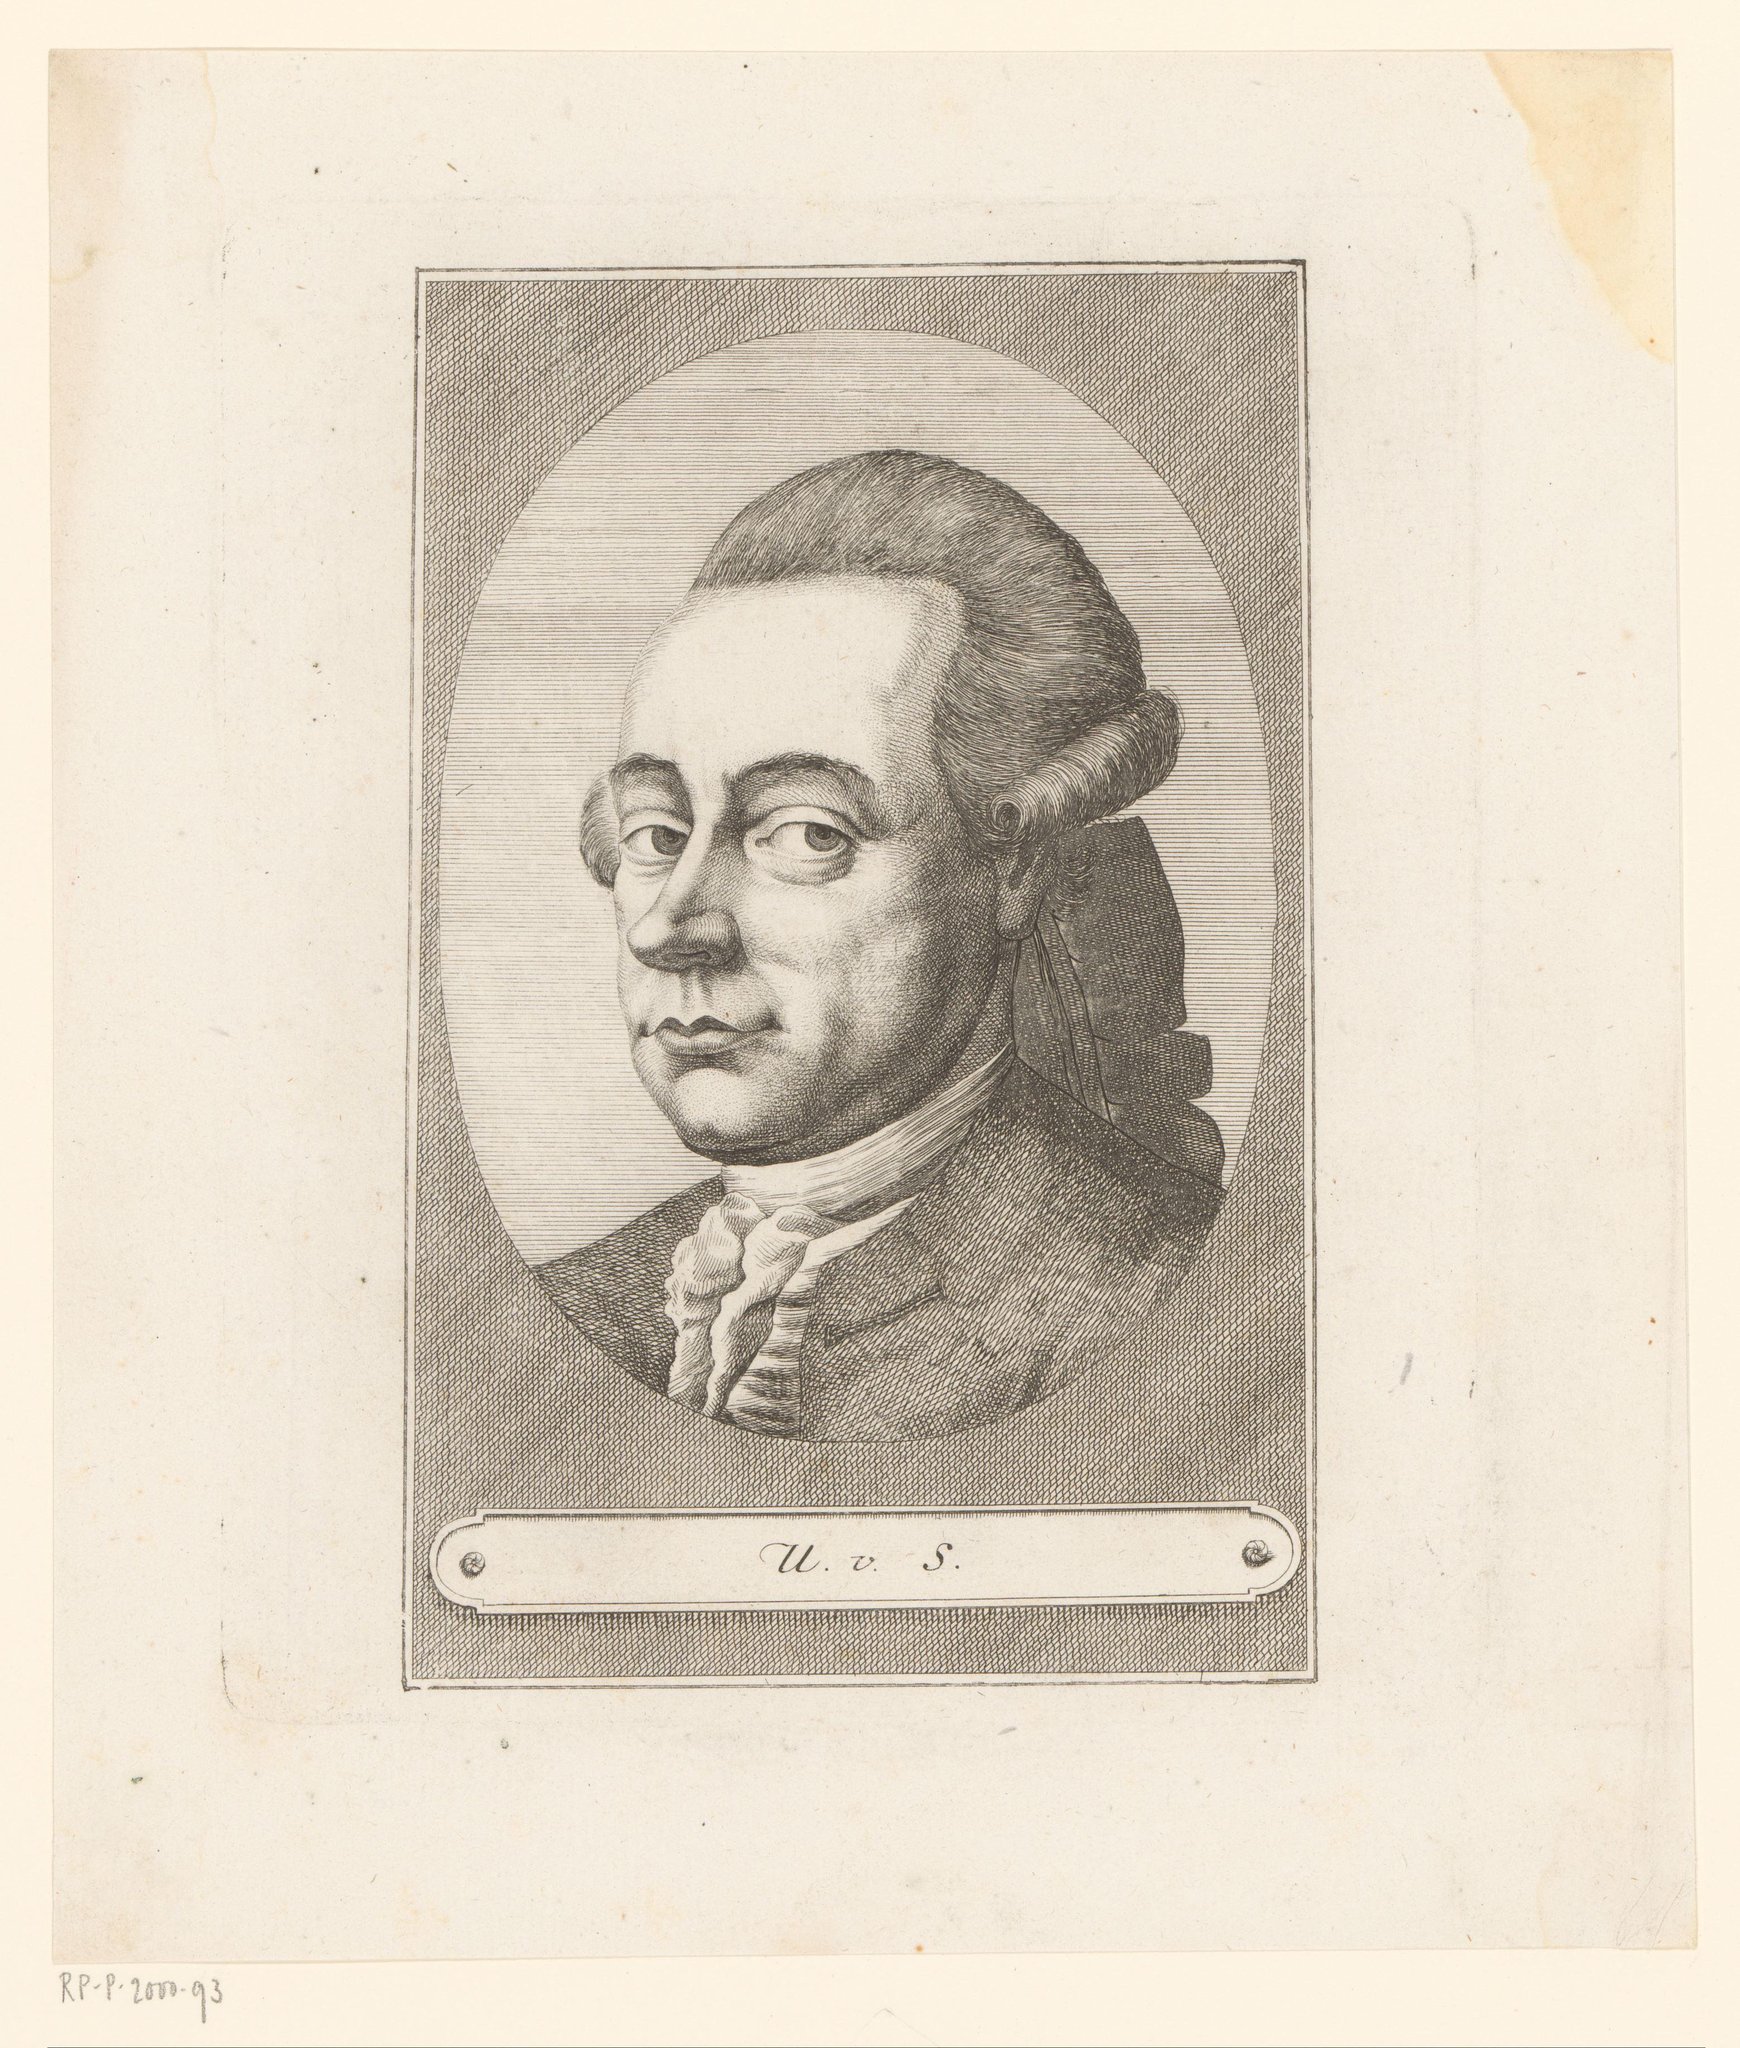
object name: print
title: Portret van U. van Salis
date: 1700-1799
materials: paper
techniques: engraving, etching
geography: germany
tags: switzerland, politician, historical persons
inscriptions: collector's mark: Lugt 2760, collector's mark: Lugt 2228